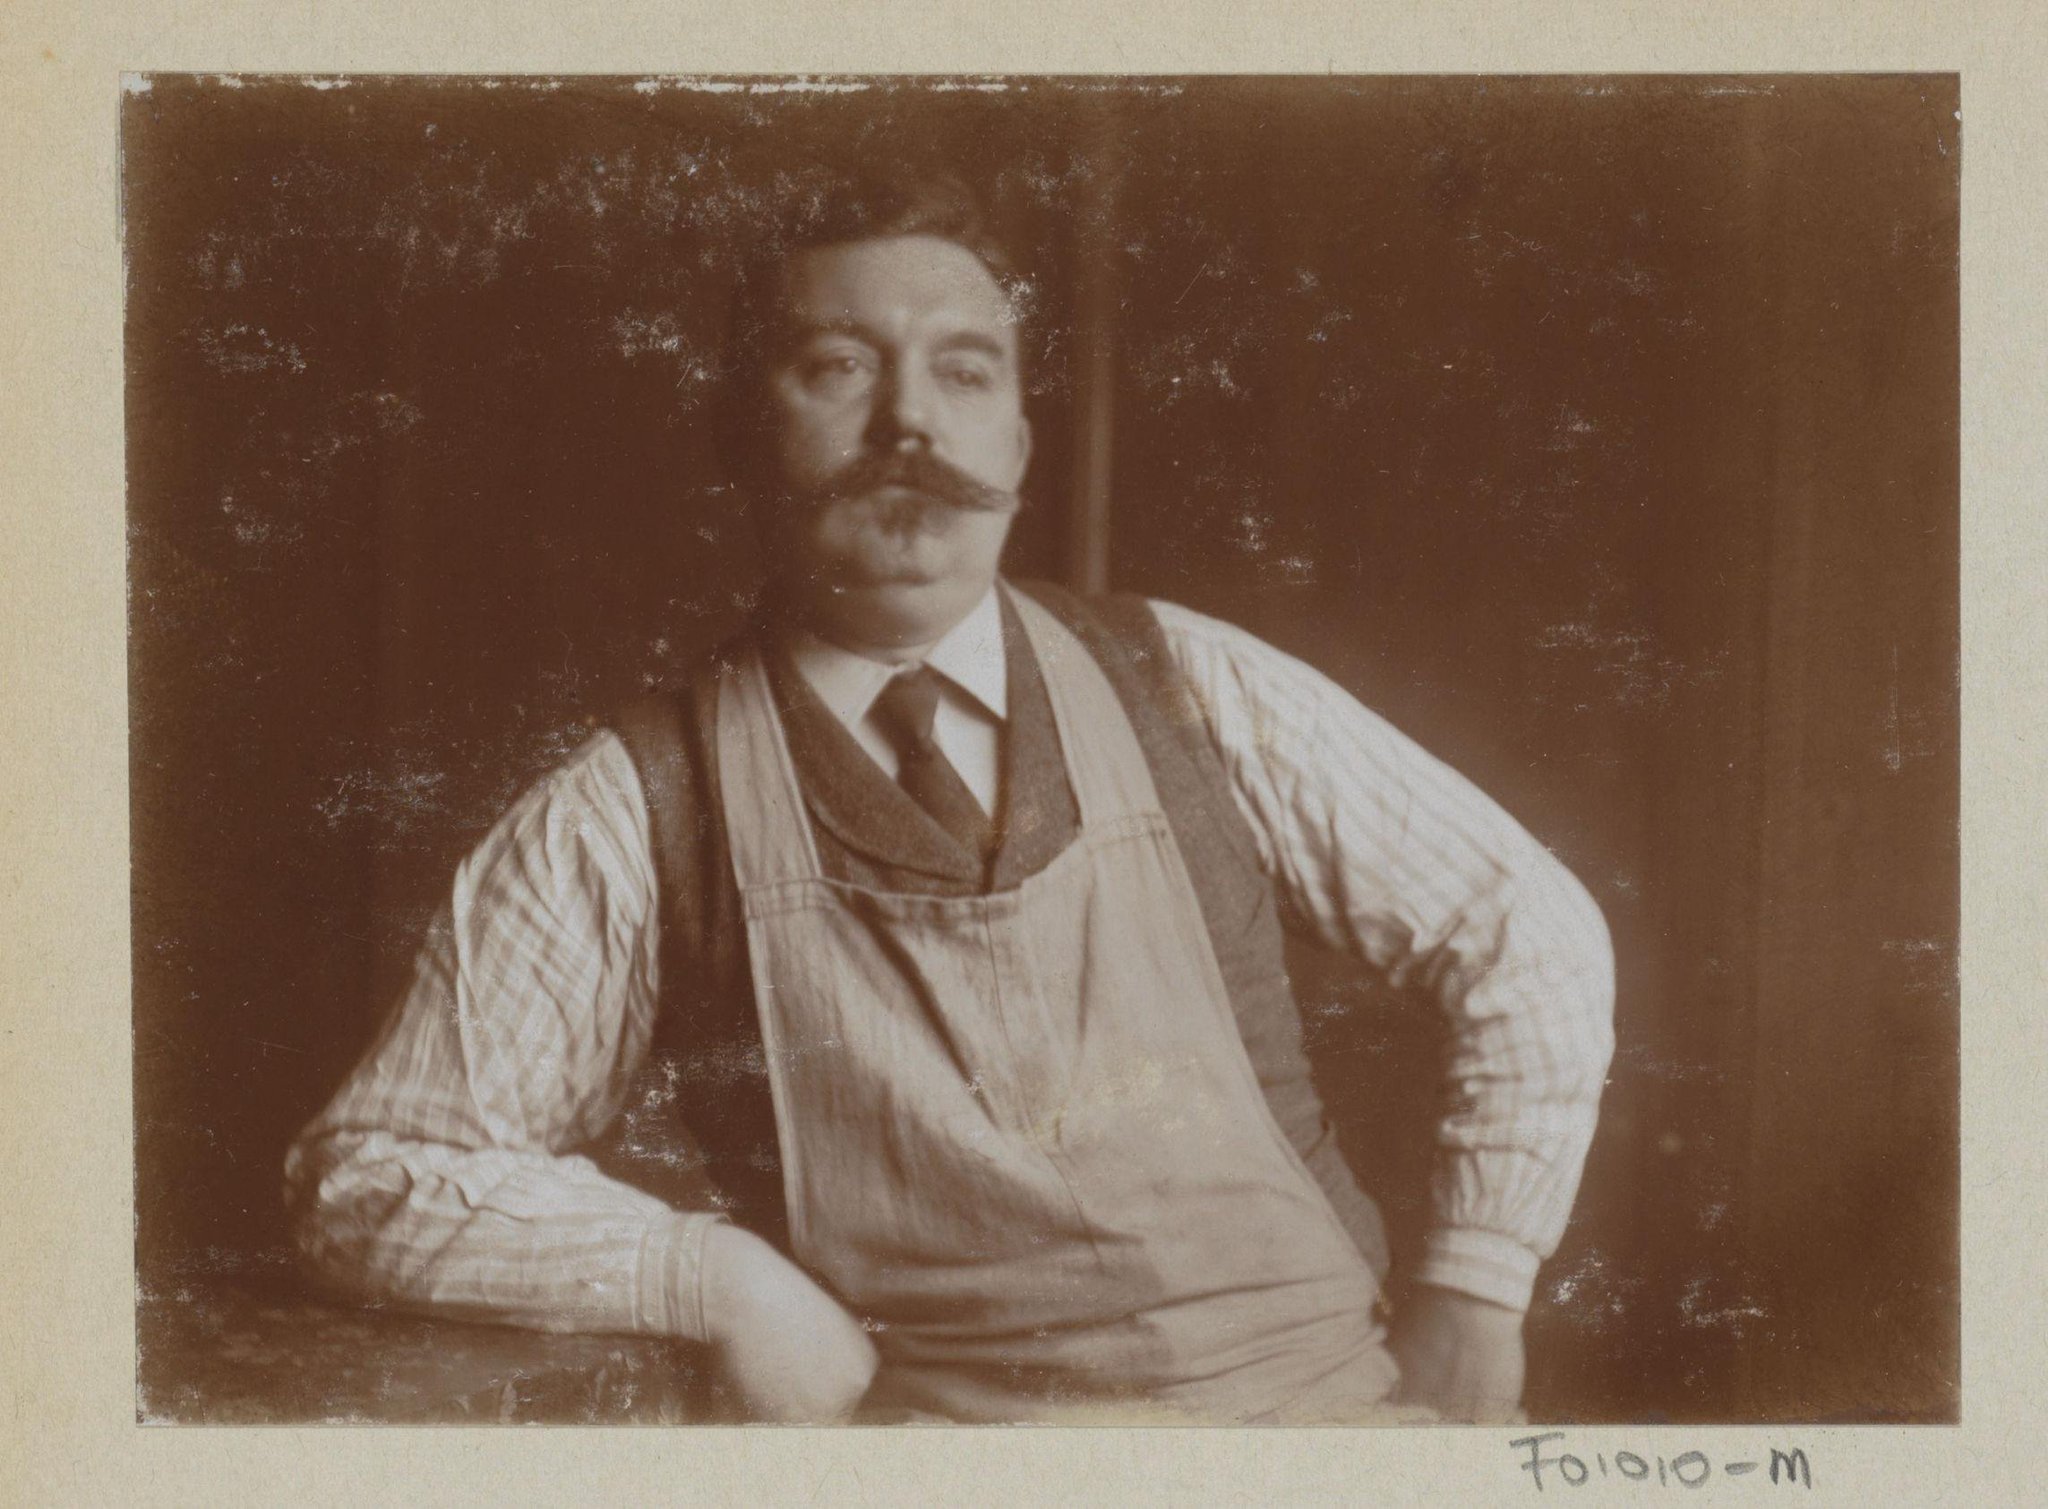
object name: photograph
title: Man, mogelijk een brouwer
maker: Anonymous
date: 1900-1910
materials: photographic support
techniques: collodion silver print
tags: brewer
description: Onderdeel van Familiealbum met onder meer foto's van Wijnhandel Kraaij & Co. Bordeaux-Amsterdam.